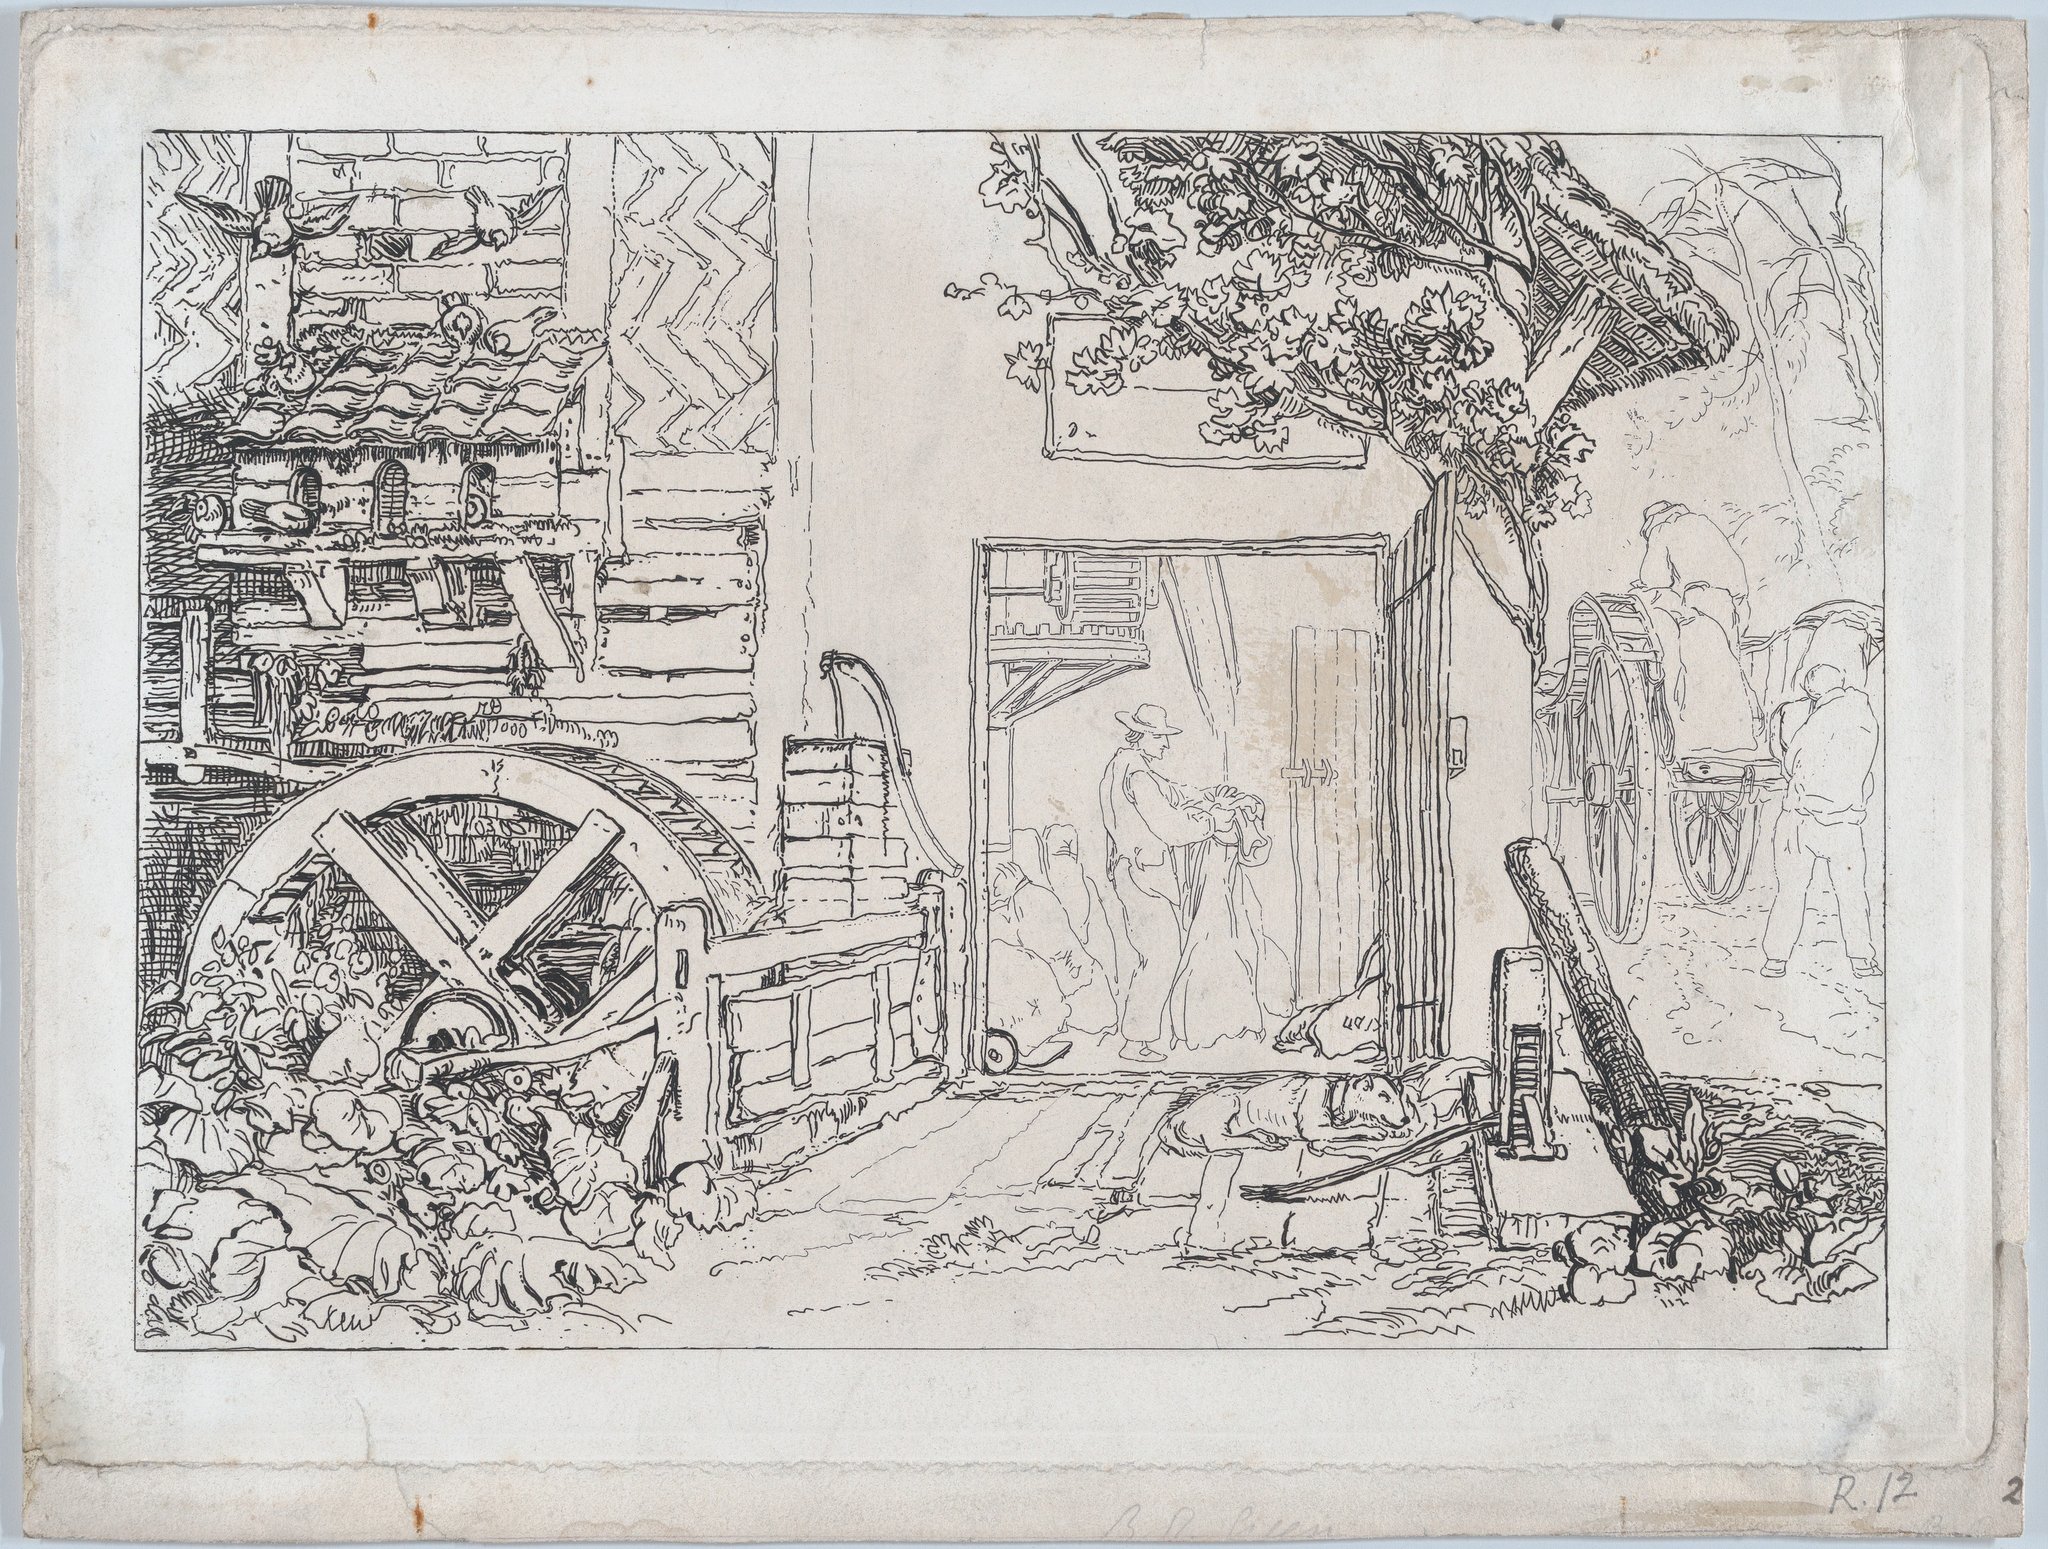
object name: print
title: Pembury Mill, Kent (Liber Studiorum, part III, plate 12)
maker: joseph mallord william turner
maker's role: artist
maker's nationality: british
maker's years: 1775-1851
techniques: etching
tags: men,dogs,working